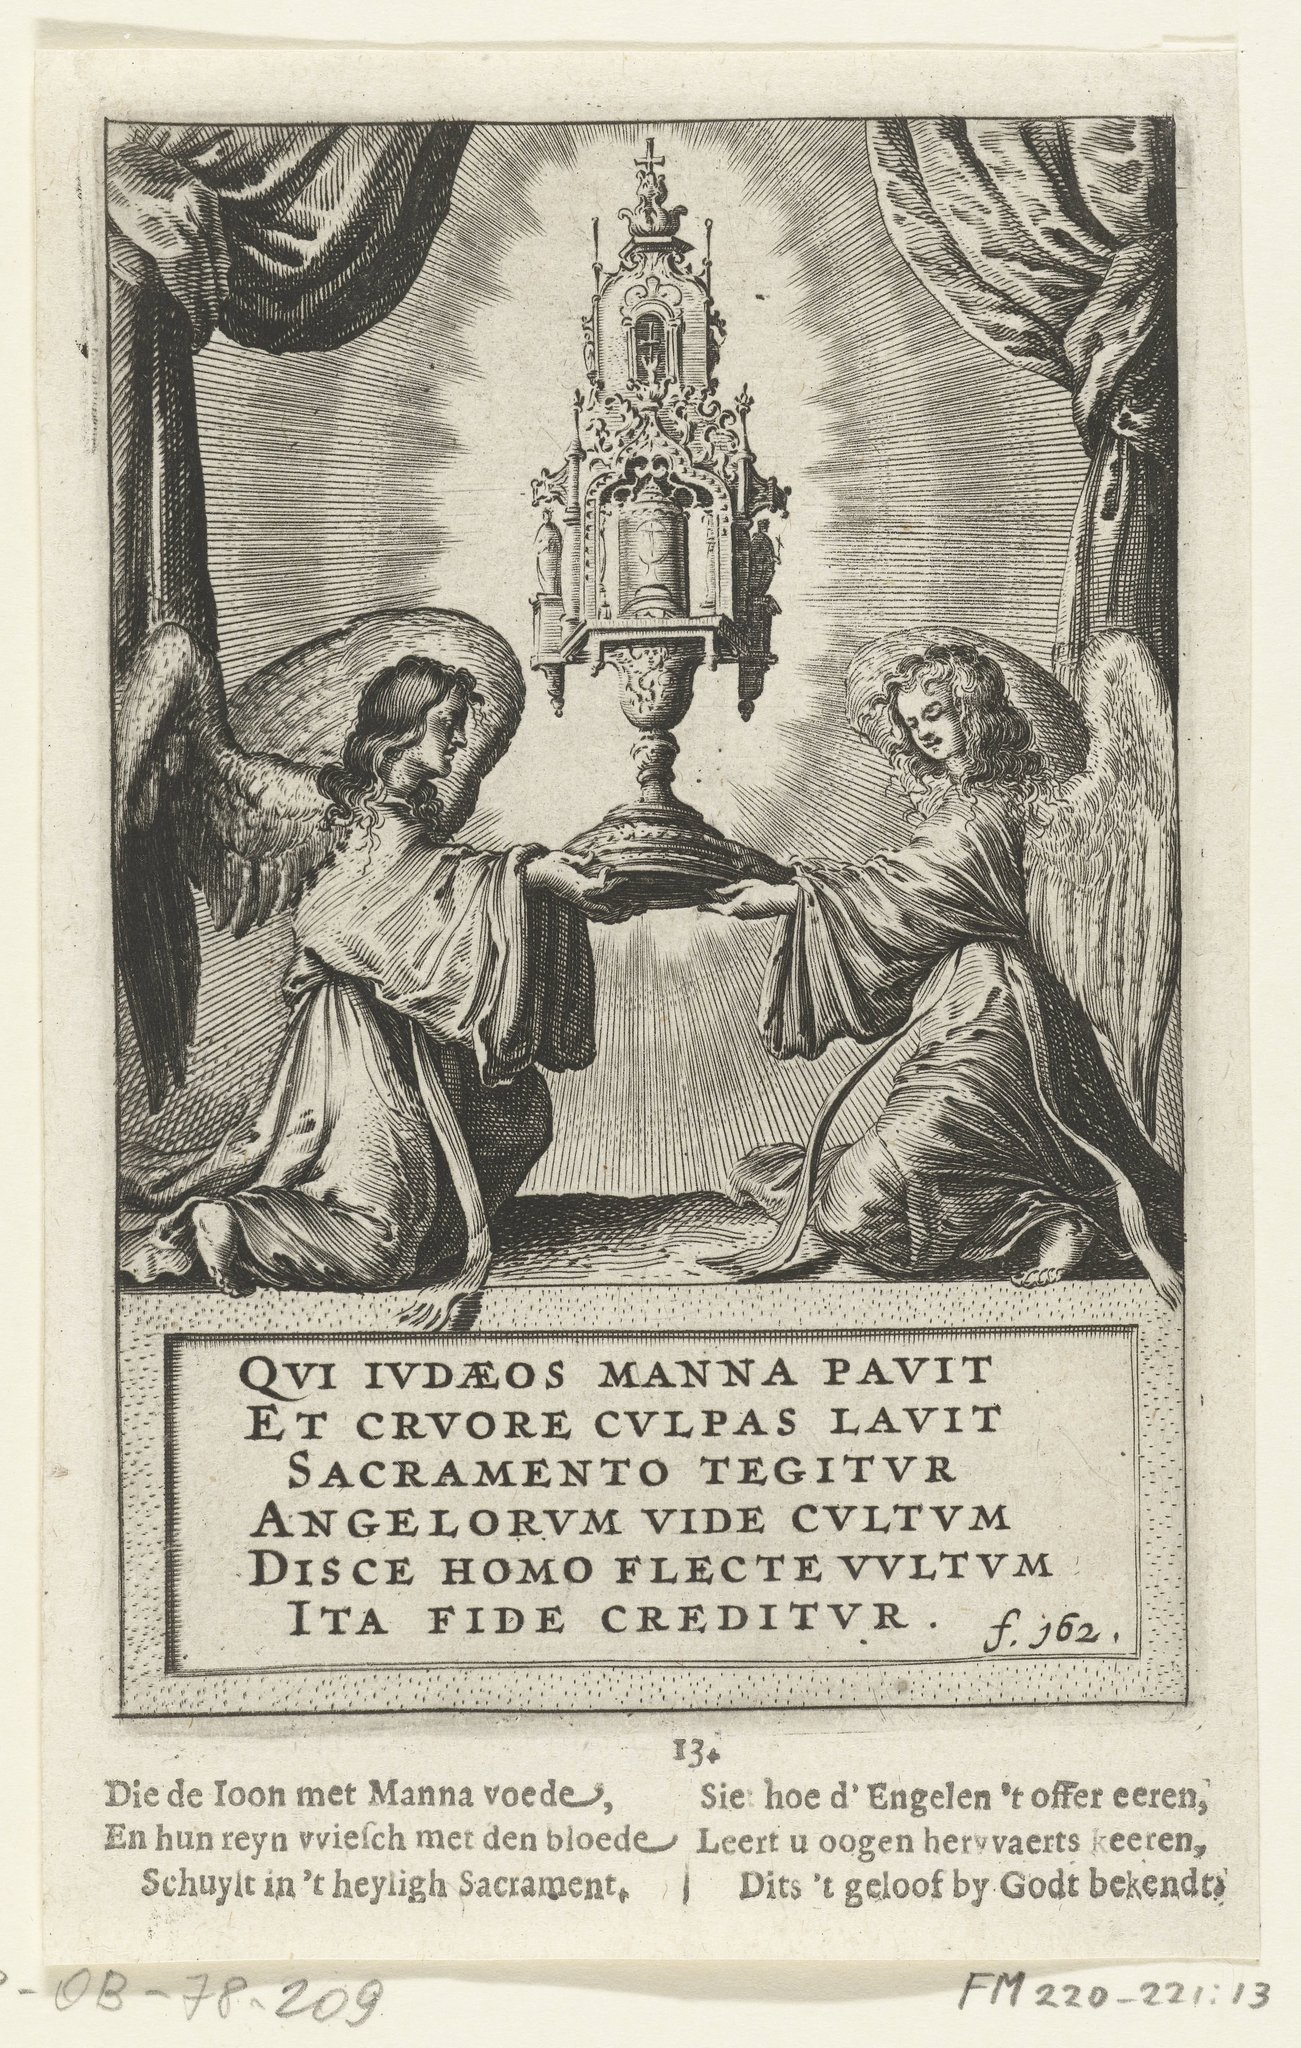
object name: print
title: Twee engelen met de monstrans met het H. Sacrament, 13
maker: Anonymous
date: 1639-1699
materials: paper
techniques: engraving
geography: low countries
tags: ostensorium, monstrance, adoration of the host, e.g. perpetual adoration, amsterdam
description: Twee engelen met een monstrans waarin het H. Sacrament. Prent nr. 13 uit de serie van 16 voorstellingen van Het Mirakel van Amsterdam, naar de gebeurtenissen op 15 maart 1345. Kopieën naar de reeks van Bolswert. Onder de voorstelling in de plaat gegraveerd een zesregelig vers in het Latijn, daaronder een zesregelig vers in boekdruk in het Nederlands.